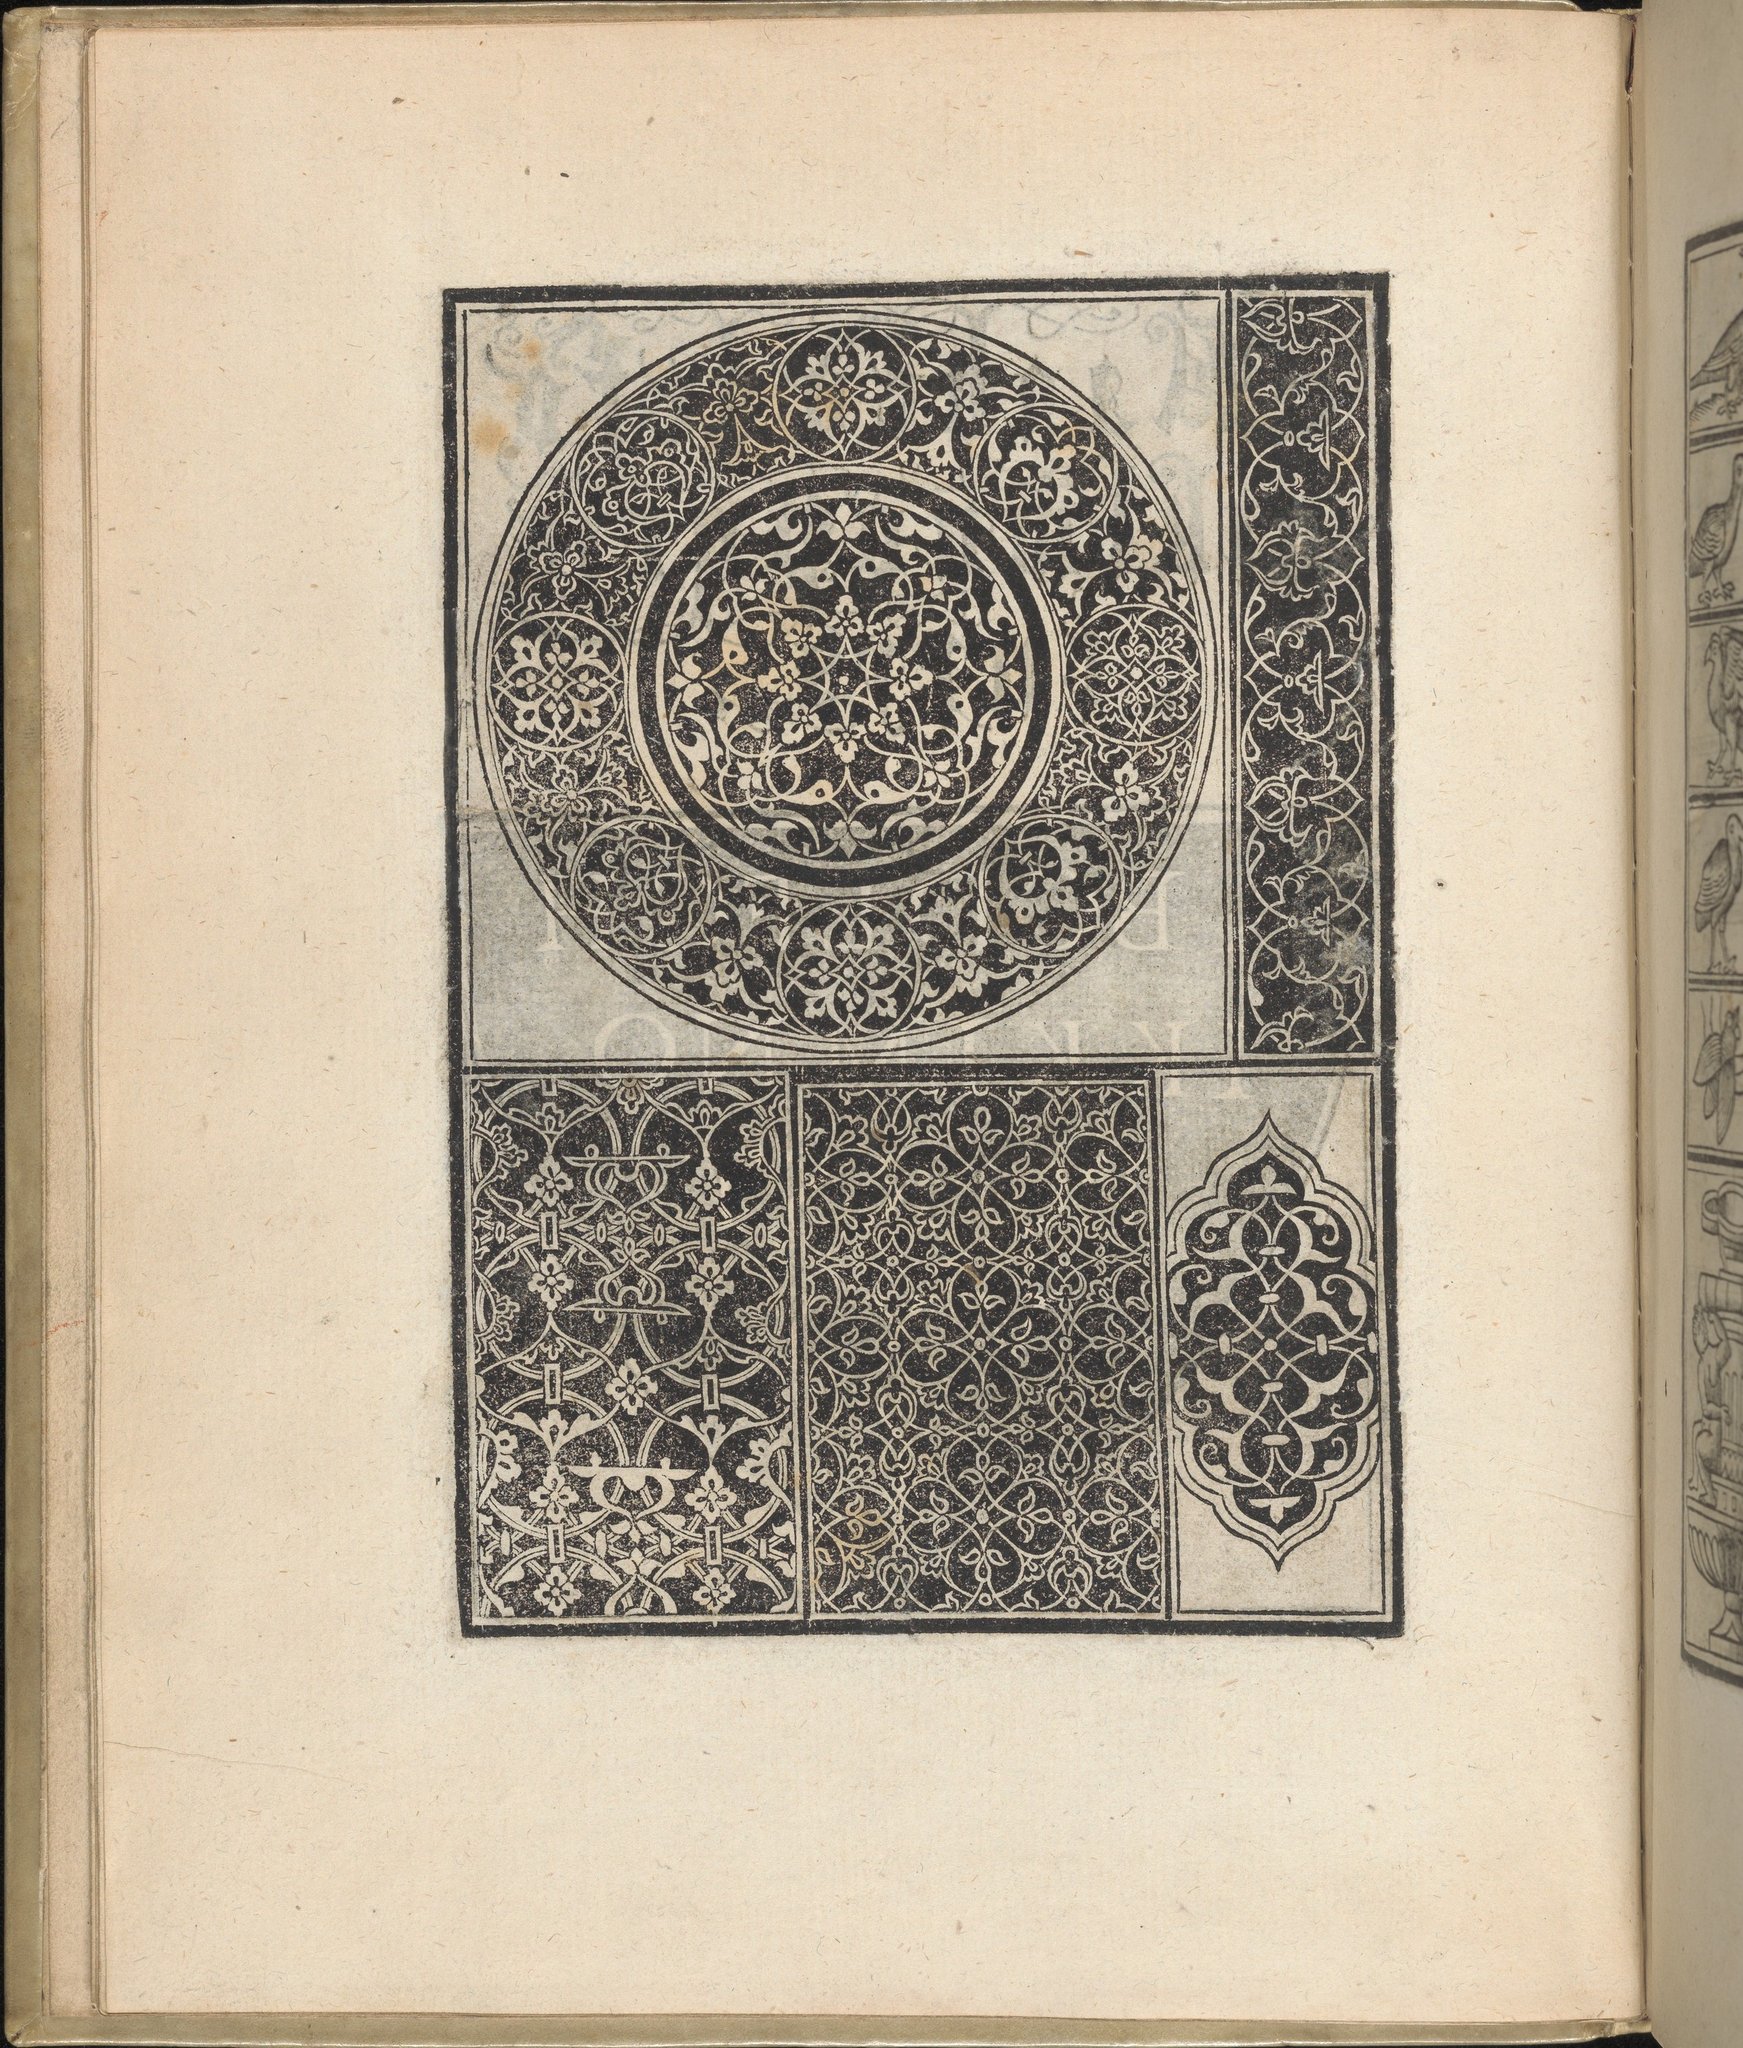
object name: book print ornament architecture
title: Trionfo Di Virtu. Libro Novo..., page 2 (verso)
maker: matteo pagano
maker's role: publisher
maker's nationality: italian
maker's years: 1515-1588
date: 1563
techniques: woodcut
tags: ornament